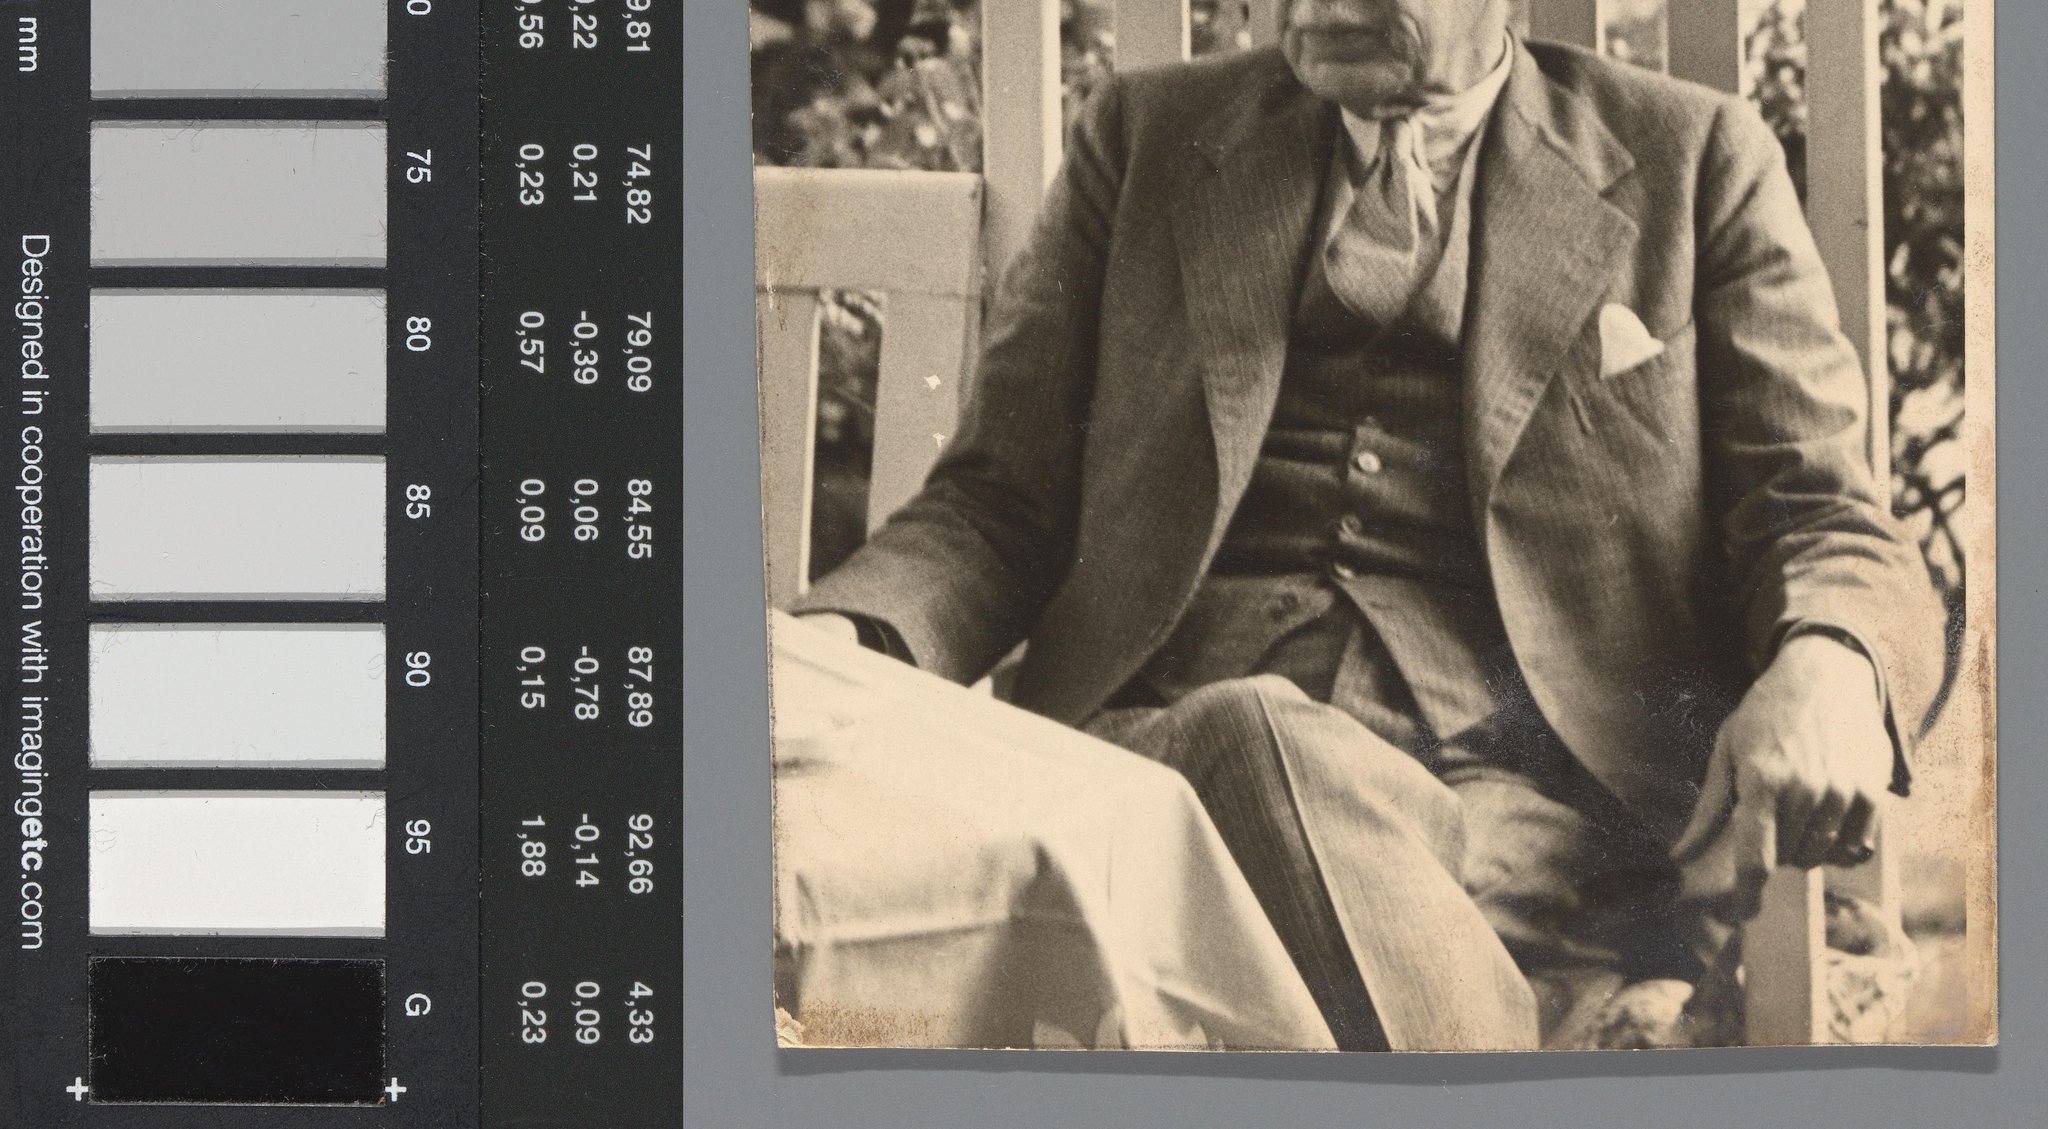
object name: photograph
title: Portret van Karel Frederik van den Berg zittend op een tuinstoel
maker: Anonymous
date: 1935-1945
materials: photographic support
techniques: photography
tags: batavia, karel frederik van den berg